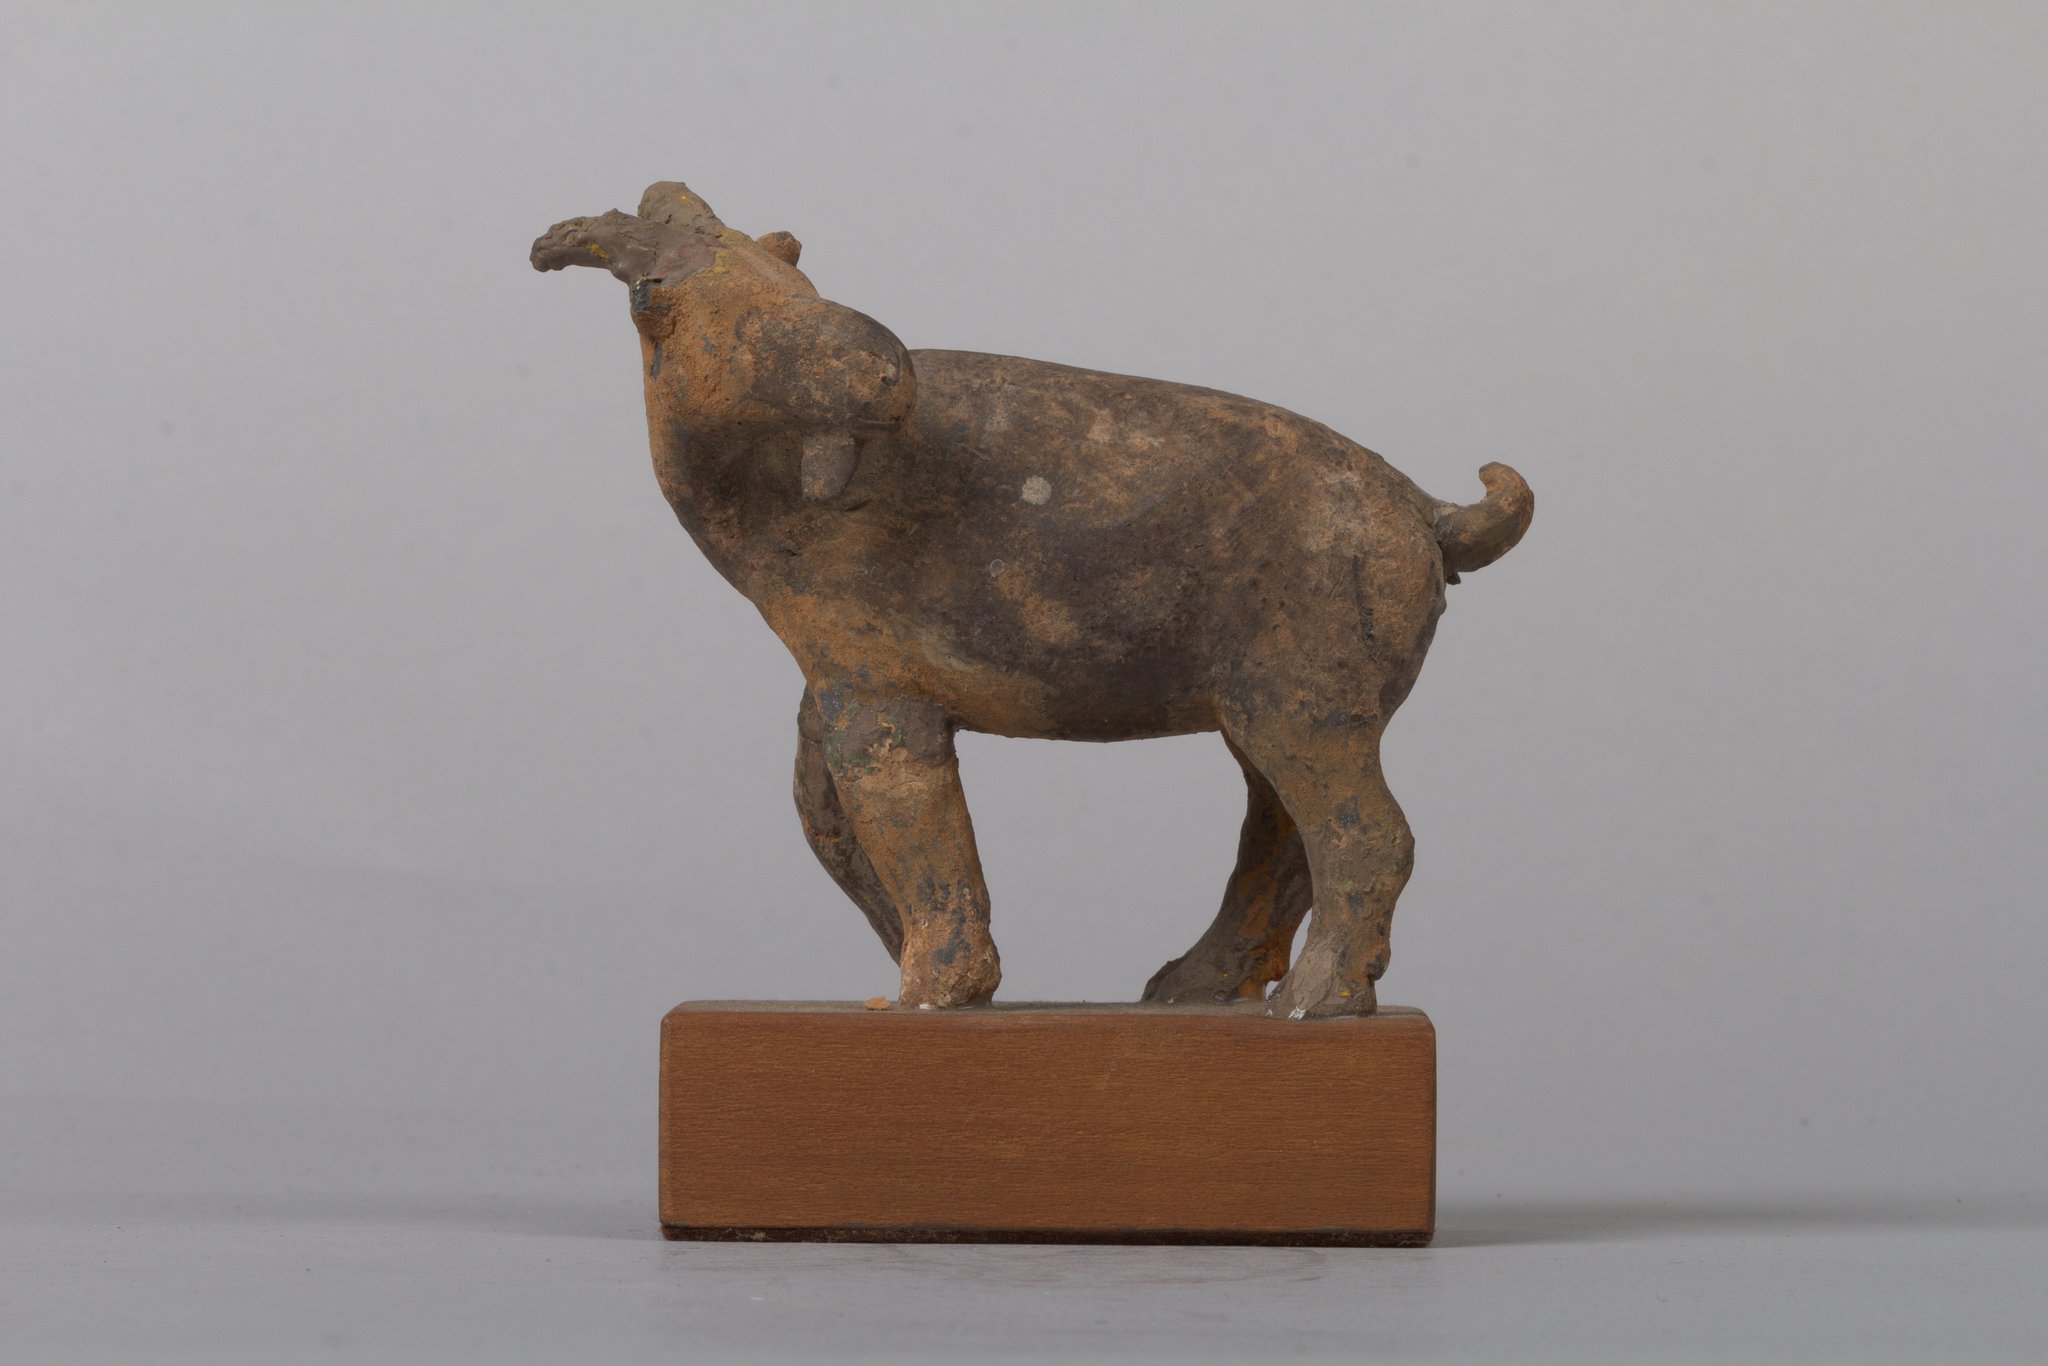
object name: figure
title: Goat (one of a pair)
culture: chinese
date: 501-600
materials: earthenware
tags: goats